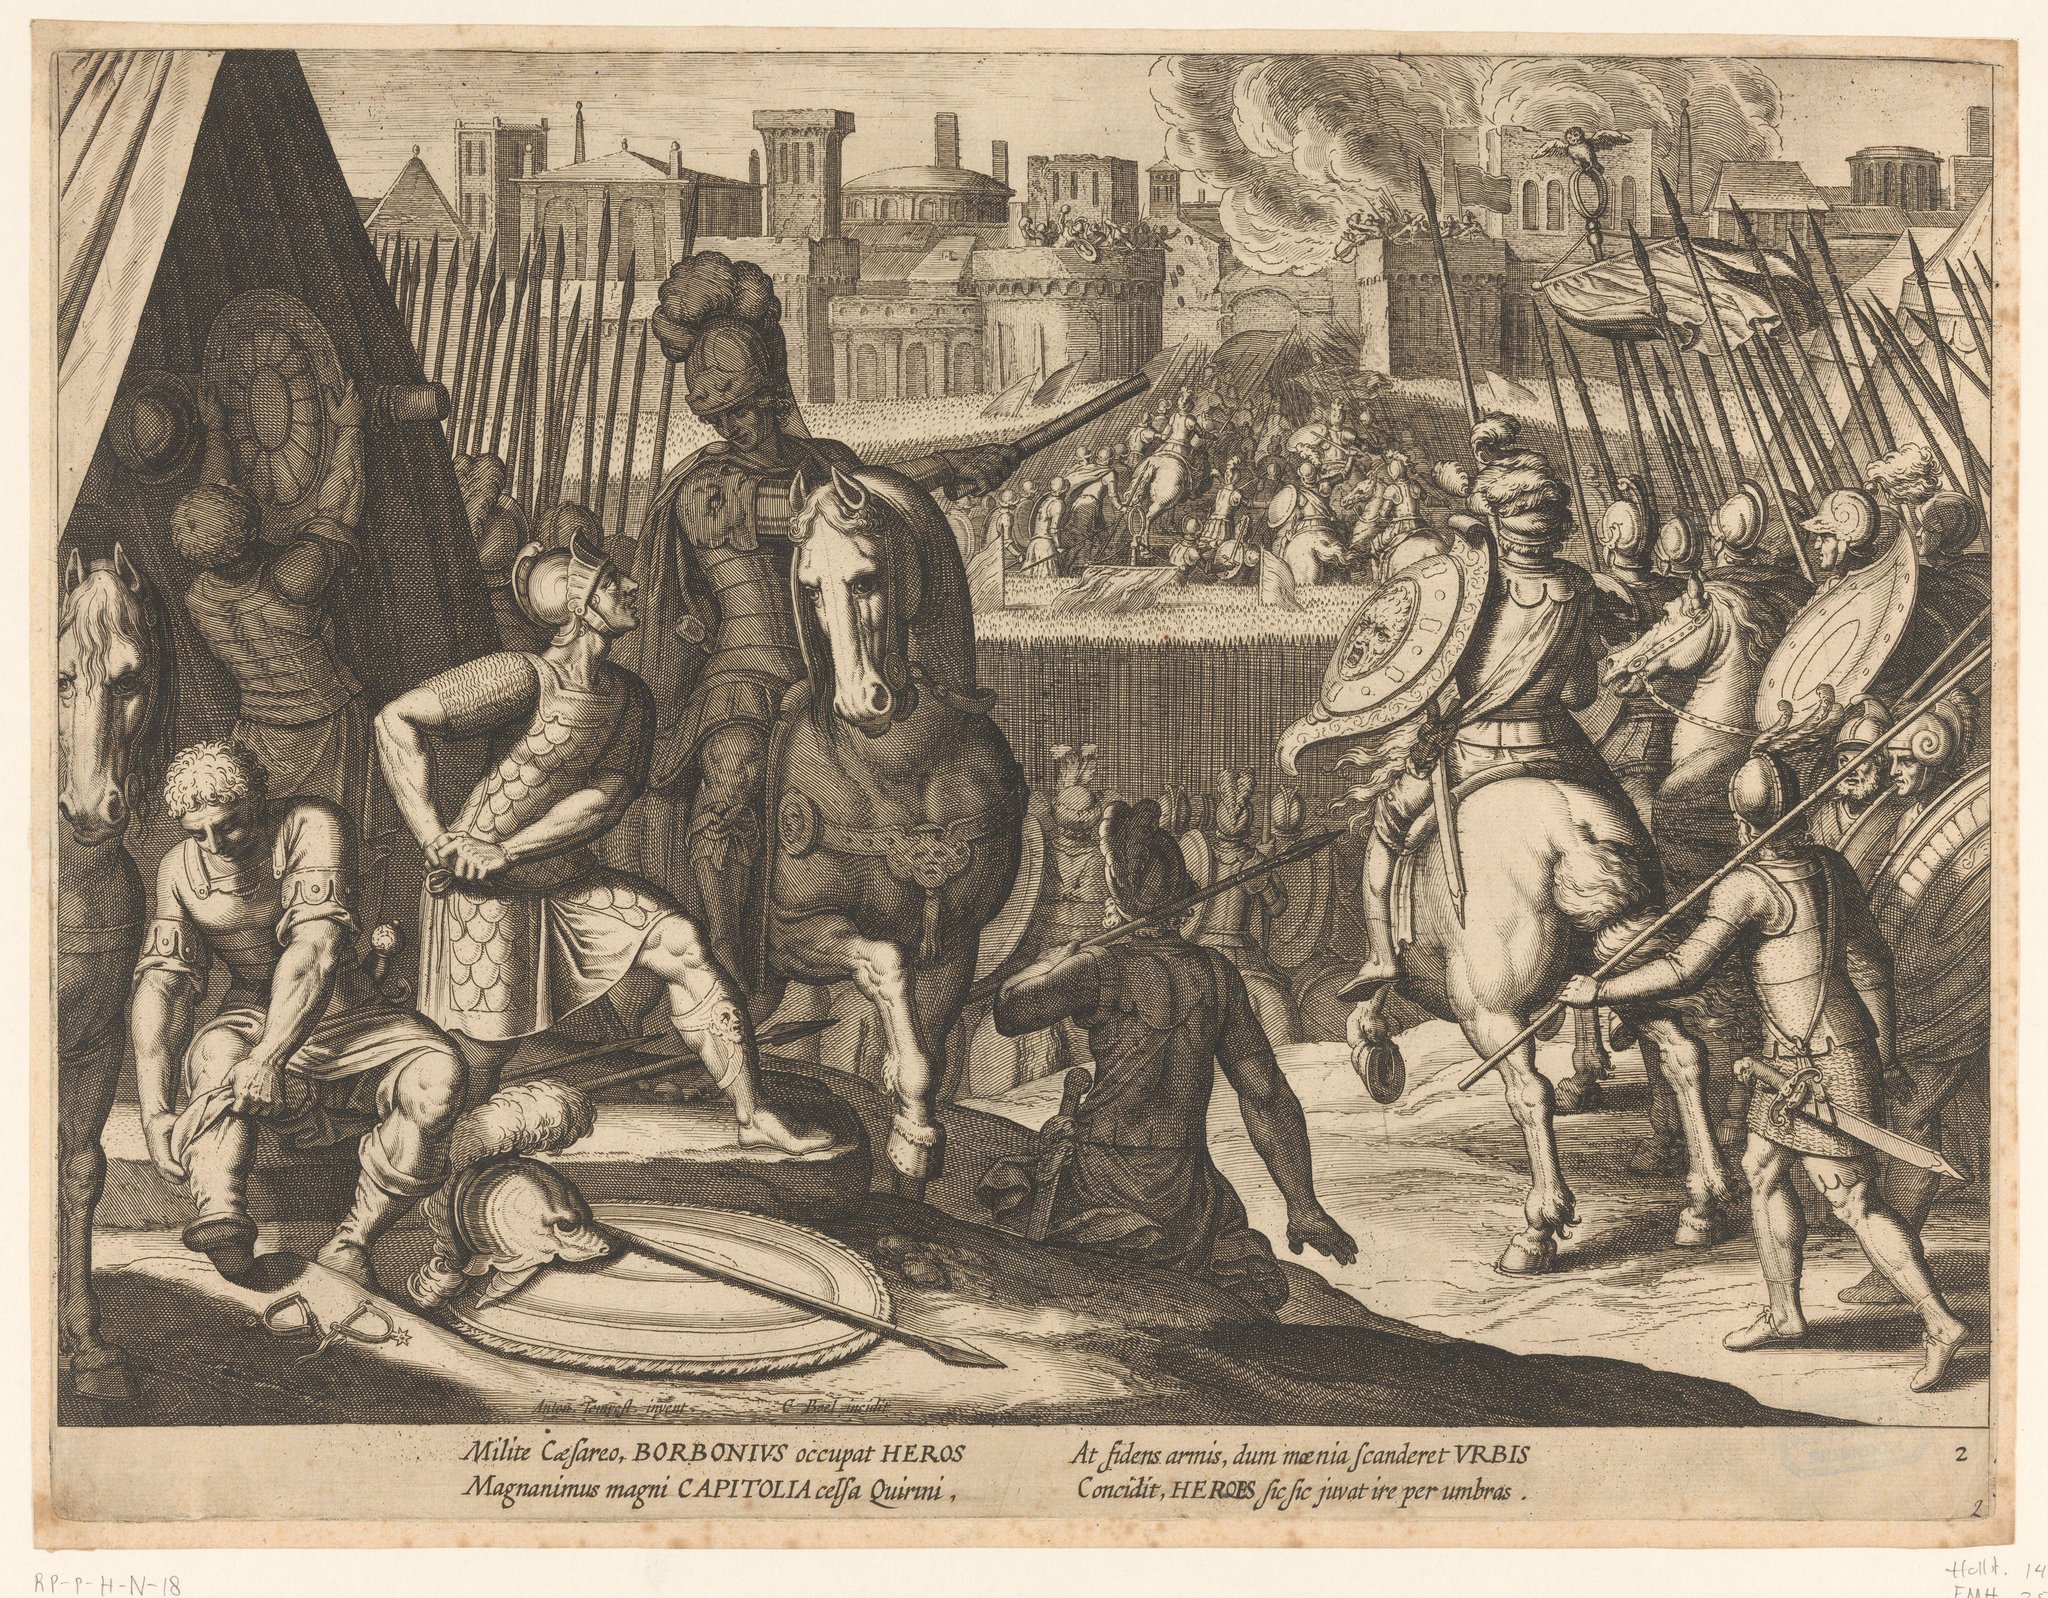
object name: print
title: Triomfen van Karel V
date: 1614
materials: paper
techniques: engraving, etching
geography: southern netherlands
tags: charles v (holy roman emperor and king of spain), battle, fighting in general, rome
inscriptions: collector's mark: Lugt 11, number: ‘N 18’, number: ‘2’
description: Karel V valt met zijn leger Rome binnen. Hij zit op een paard en wijst met zijn commandostaf naar de stad. Naast hem kleden soldaten zich aan. Op de achtergrond vallen de troepen al de stad binnen. Met onderschrift van vier regels in het Latijn. Deze prent is onderdeel van een reeks van acht prenten, elk een triomf van Karel V voorstellende.